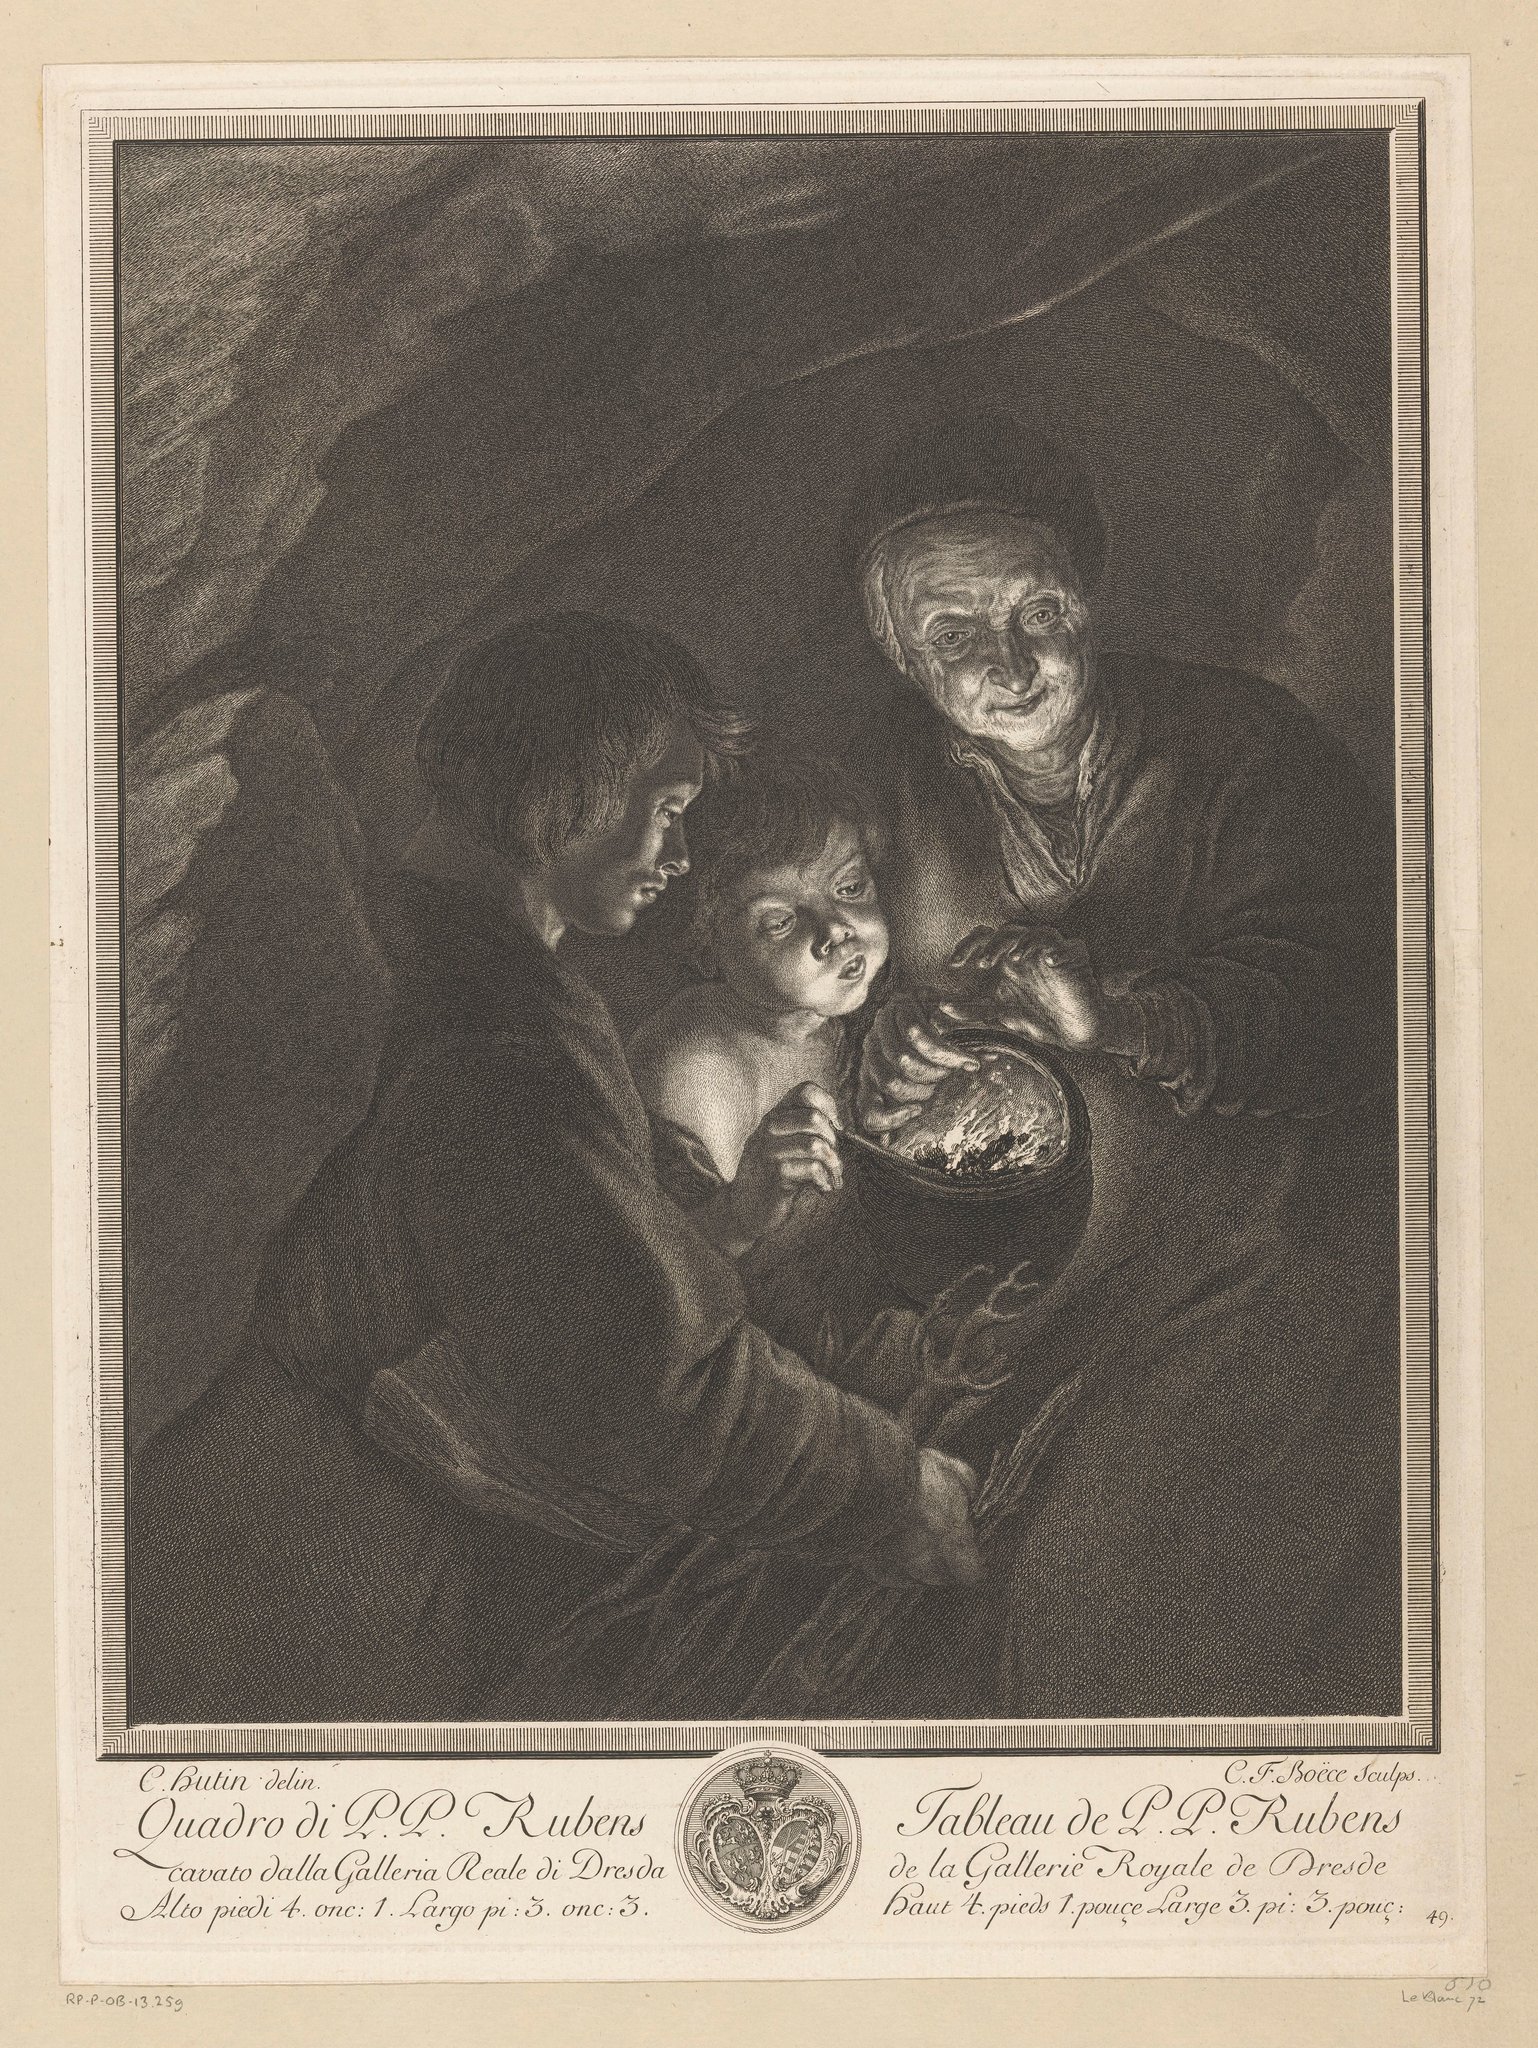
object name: print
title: Recueil d'estampes d'après les plus célèbres tableaux de la Galerie Royale de Dresde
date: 1753-1757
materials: paper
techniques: engraving, etching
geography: dresden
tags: armorial bearing, heraldry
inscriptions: collector's mark: Lugt 240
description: Prent naar het schilderij in de Gemäldegalerie Alte Meister in Dresden (Gal.-Nr. 958). Prent afkomstig uit de 'Recueil d'estampes d'après les plus célèbres tableaux de la Galerie Royale de Dresde', verschenen in twee delen in 1753 en 1757, met in totaal 100 prenten naar schilderijen in de koninklijke kunstcollecties te Dresden.